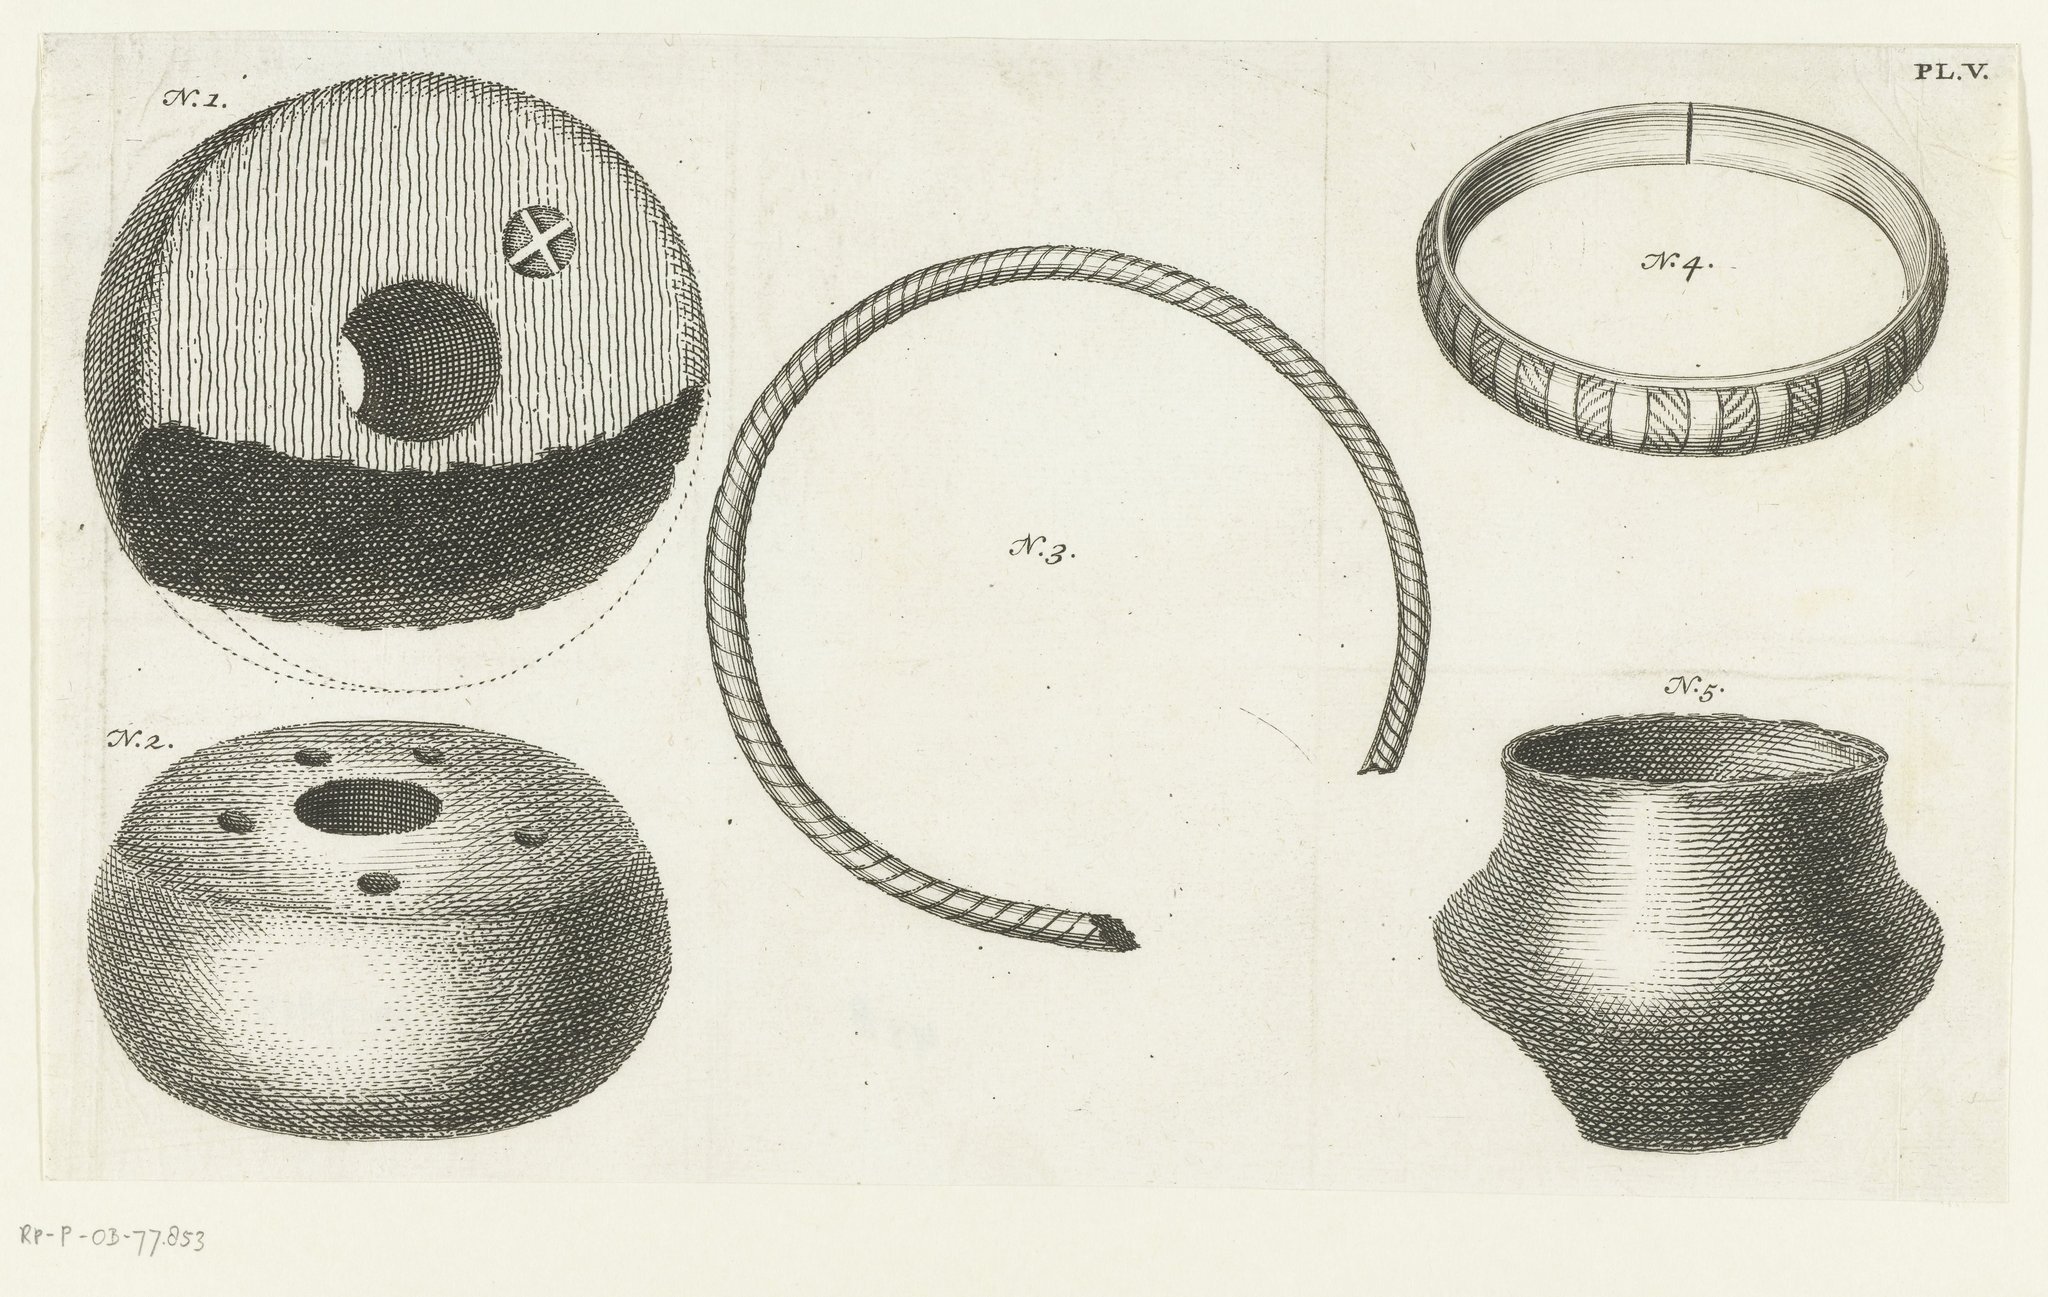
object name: historical object representation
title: Voorwerpen uit een grafkelder bij Eext, pl. V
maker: Anonymous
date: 1758-1760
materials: paper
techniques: etching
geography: netherlands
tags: eext, prehistorie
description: Illustratie voor: Joannes van Lier, Oudheidkundige brieven : bevattende eene verhandeling over de manier van begraven, en over de lykbusschen, wapenen, veld- en eertekens, der oude Germanen, en in het byzonder de beschryving van eenen alouden steenen grafkelder, met de daarin gevondene lykbusschen, donderkeilen en donderbylen, enz. by het boerschap Eext, in het landschap Drenthe, Pieter van Thol, ’s-Gravenhage 1760. Plaat V.